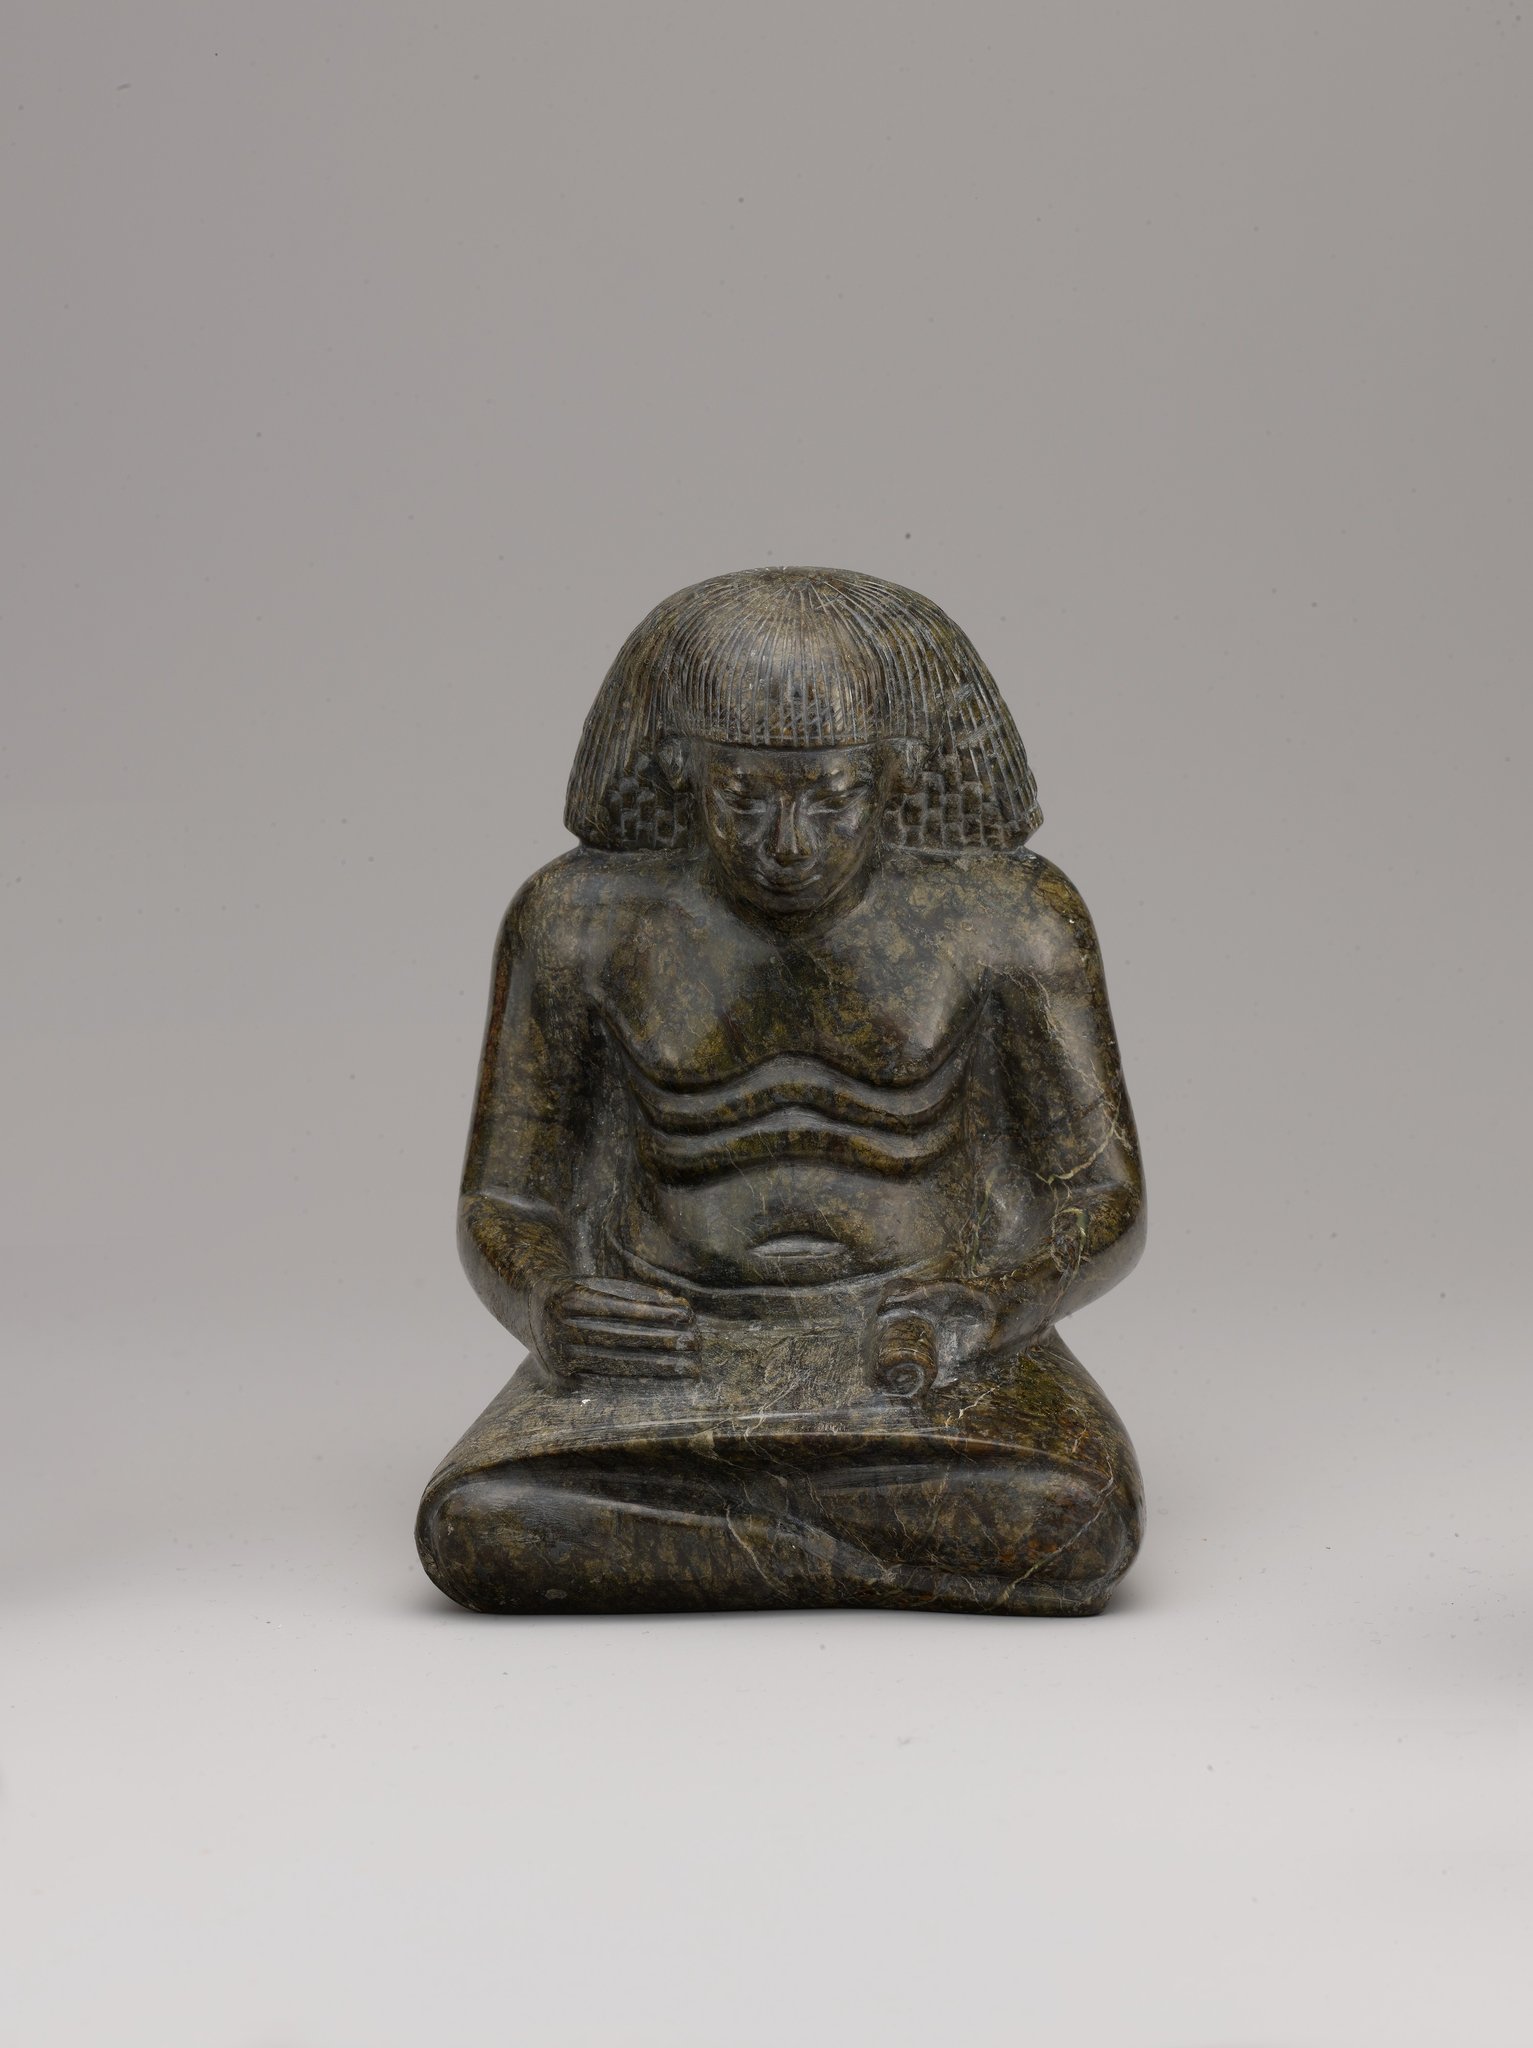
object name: statue, scribe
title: Statuette of a Scribe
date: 1391-1353 BCE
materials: stone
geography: egypt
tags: men